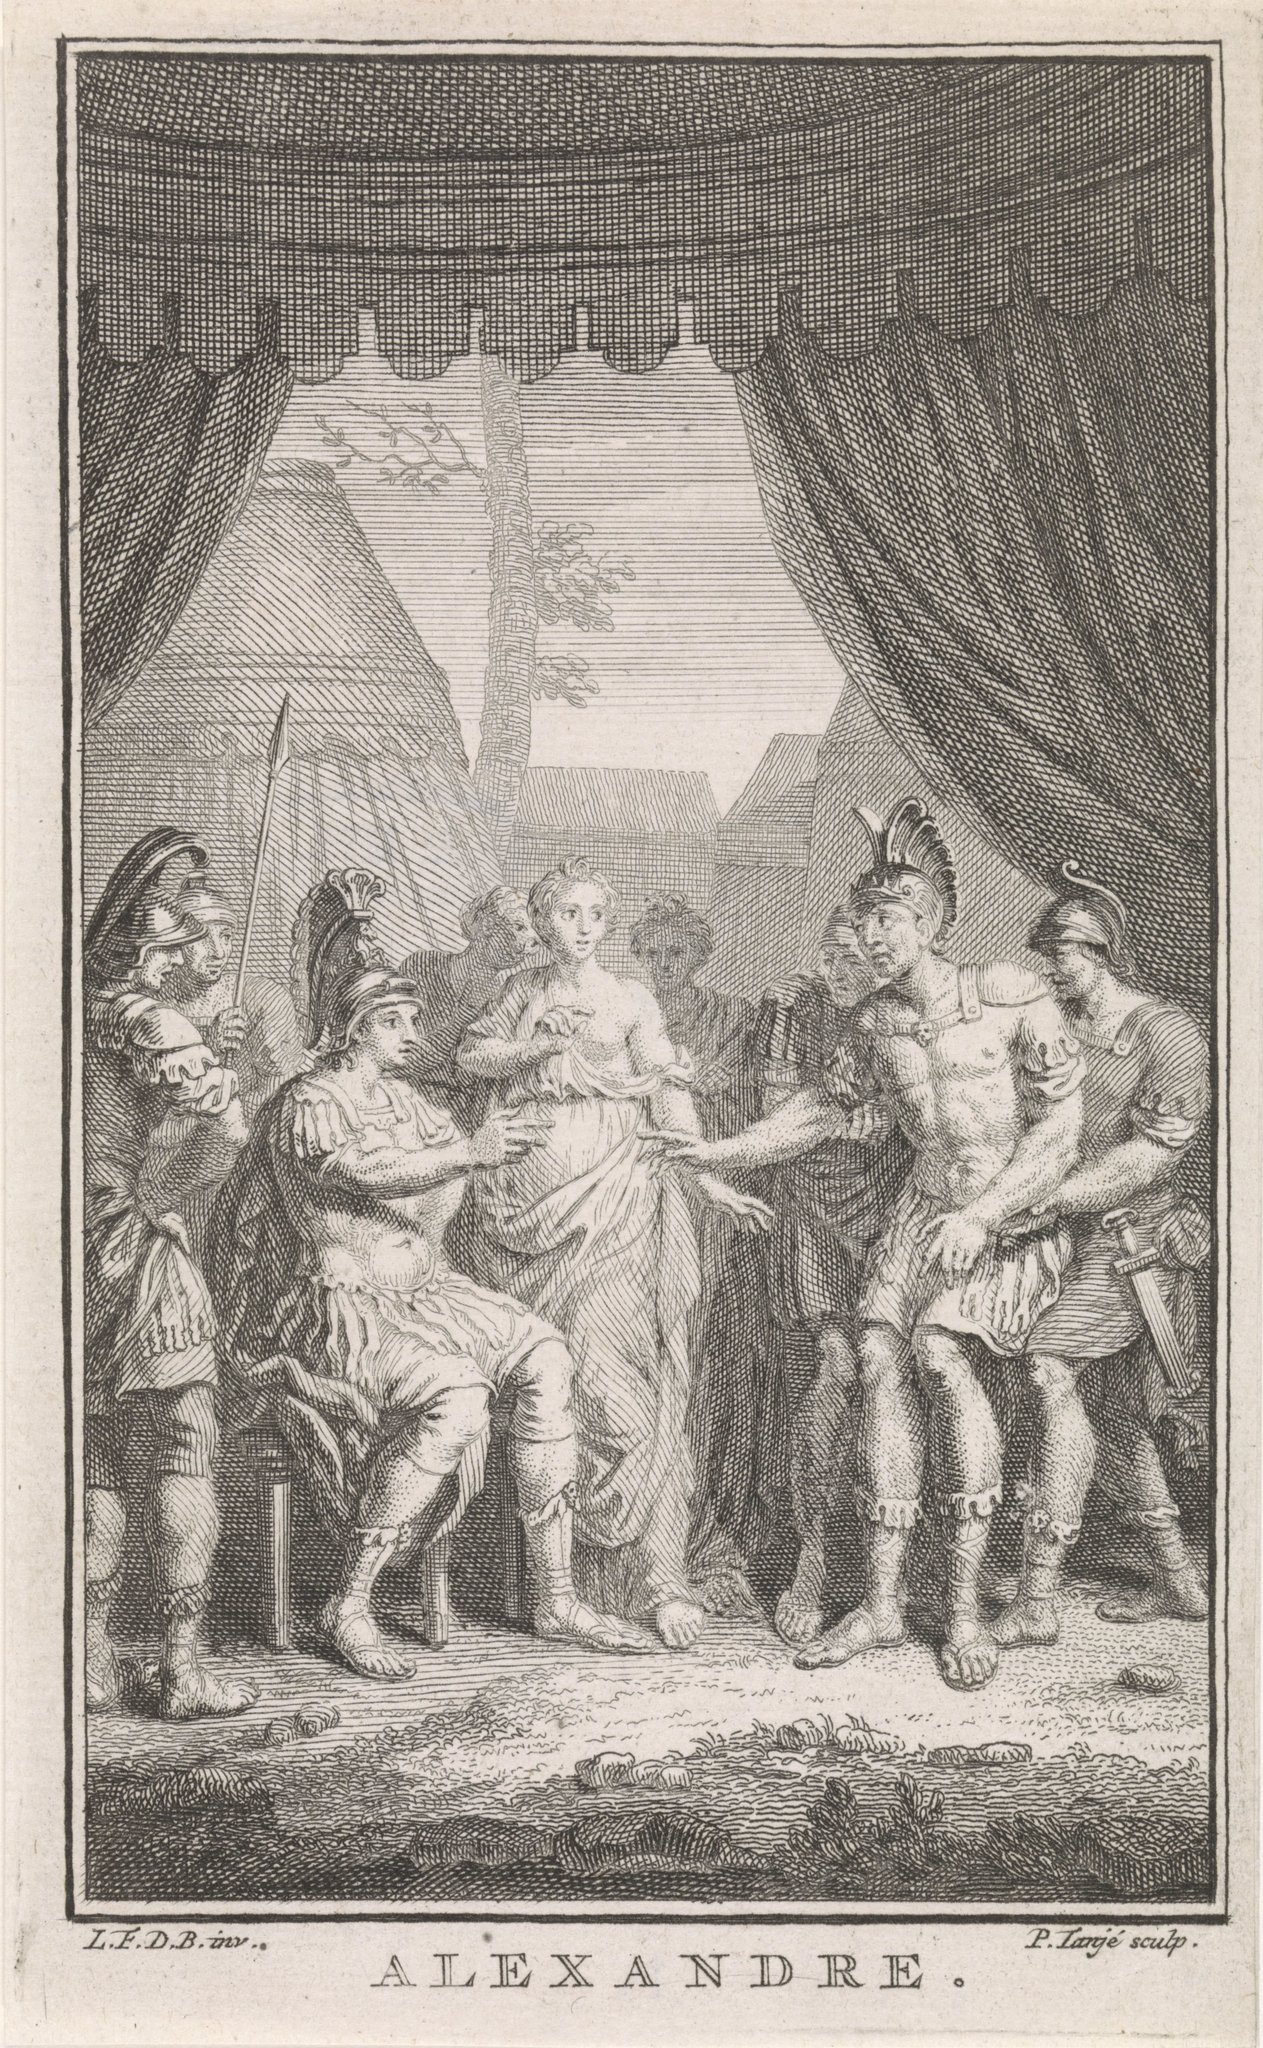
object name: book illustration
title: Alexander de Grote onder een baldakijn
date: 1743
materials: paper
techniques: engraving, etching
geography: amsterdam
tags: (story of) alexander the great, tragedy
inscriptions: collector's mark: Lugt 2228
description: Alexander de Grote gezeten op een stoel met prinses Cleofile aan zijn zijde. Een man wordt door een soldaat naar Alexander geleid. Boekillustratie bij de tragedie 'Alexandre le Grand' van Jean Baptiste Racine.